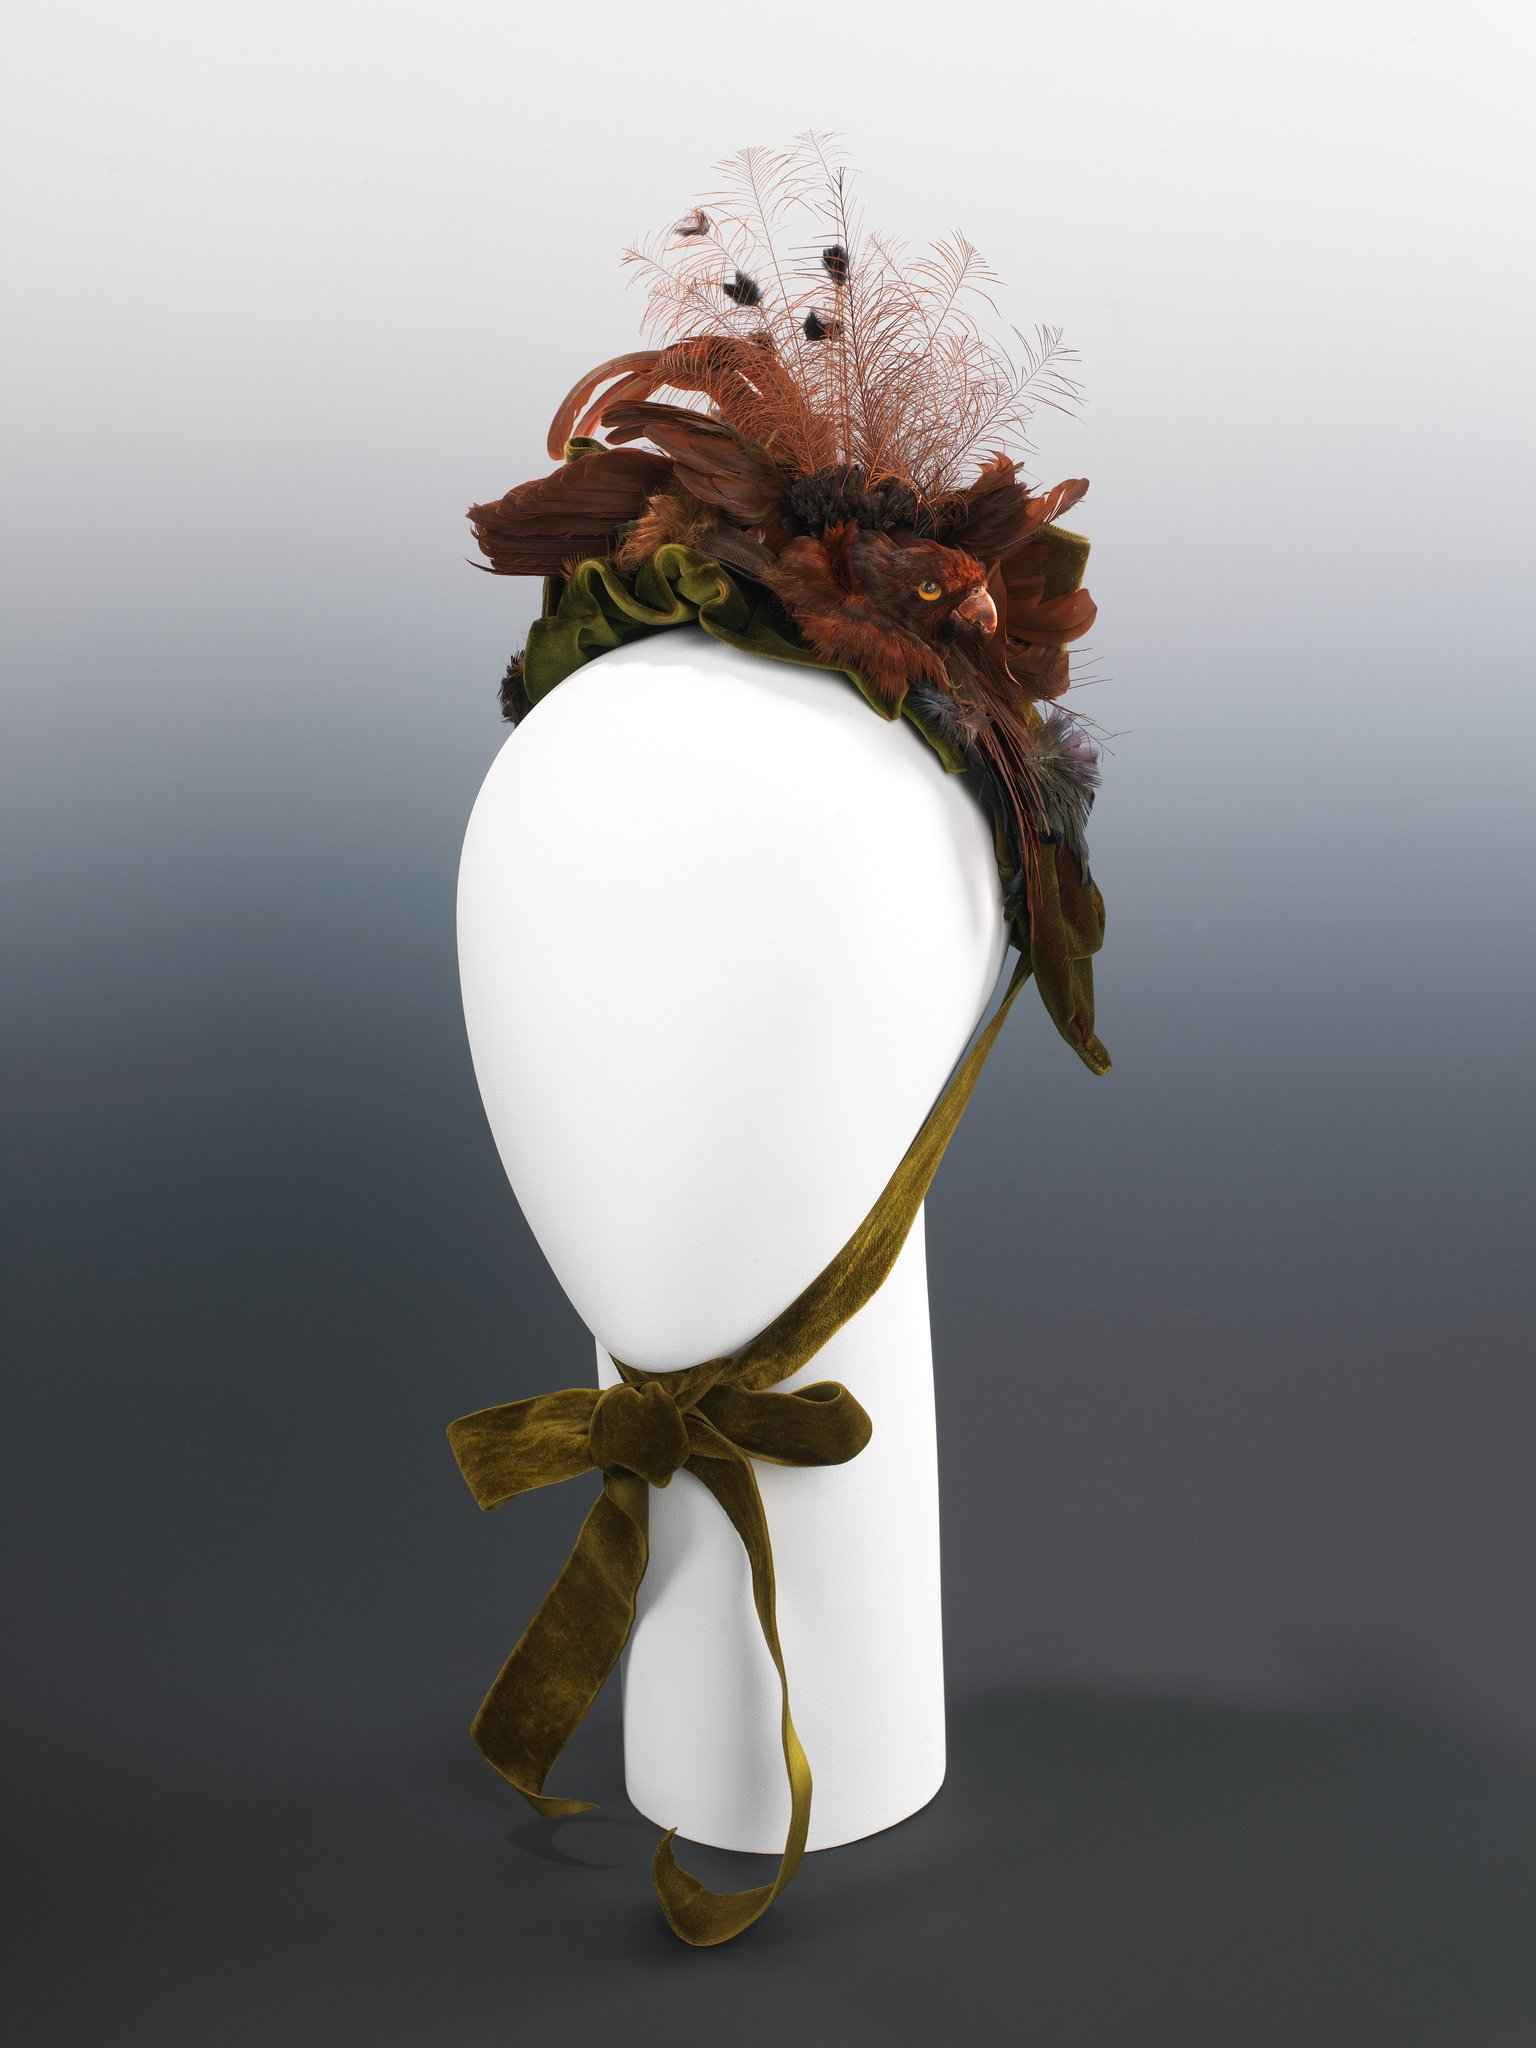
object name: bonnet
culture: french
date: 1880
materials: feather, silk